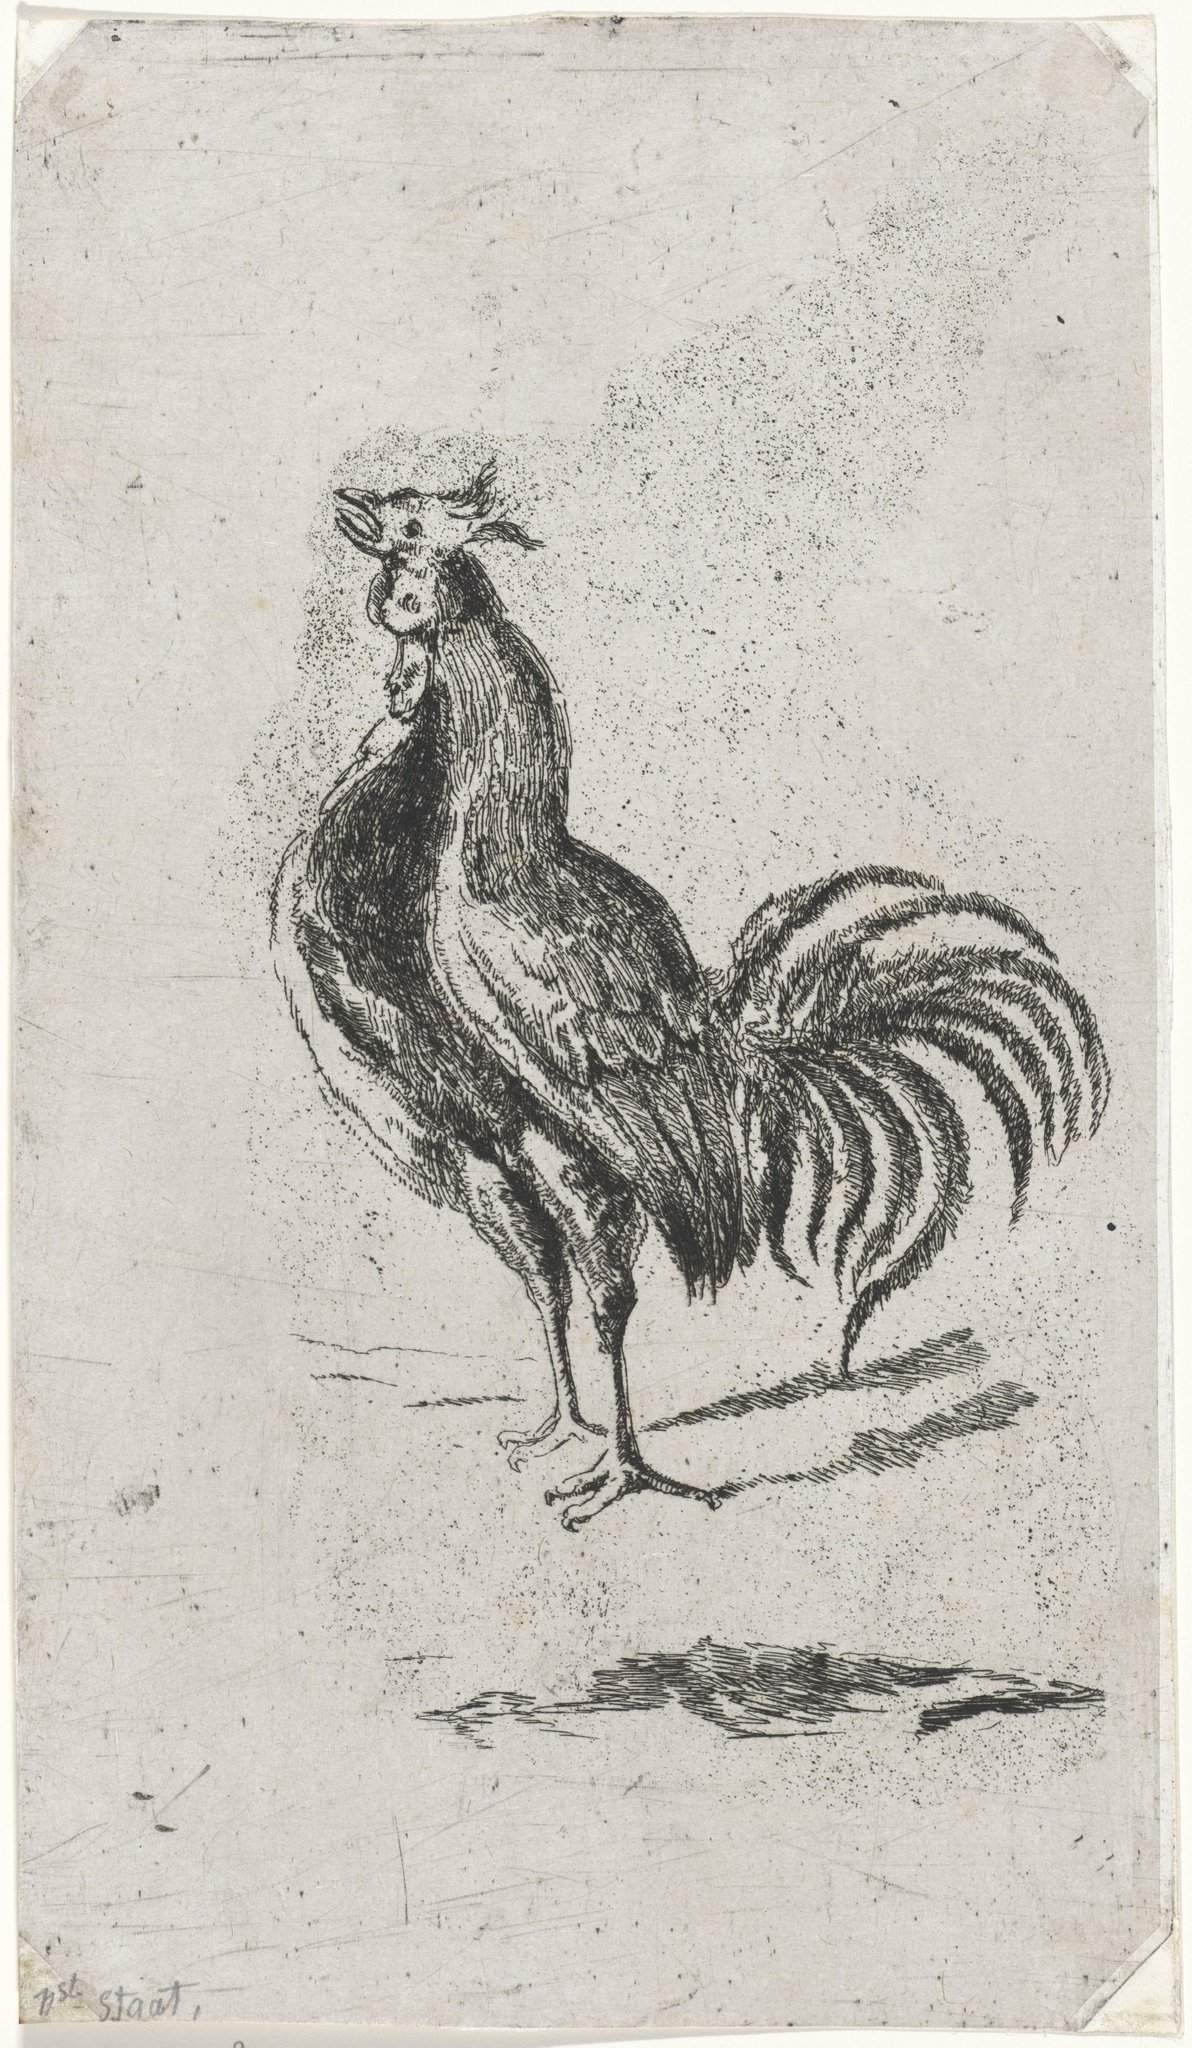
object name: print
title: Haan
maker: arnoud schaepkens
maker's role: print maker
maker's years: 1816-1904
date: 1831-1904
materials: paper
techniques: drypoint, etching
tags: fowl (cock, hen, chicken, etc.)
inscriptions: collector's mark: Lugt 2228